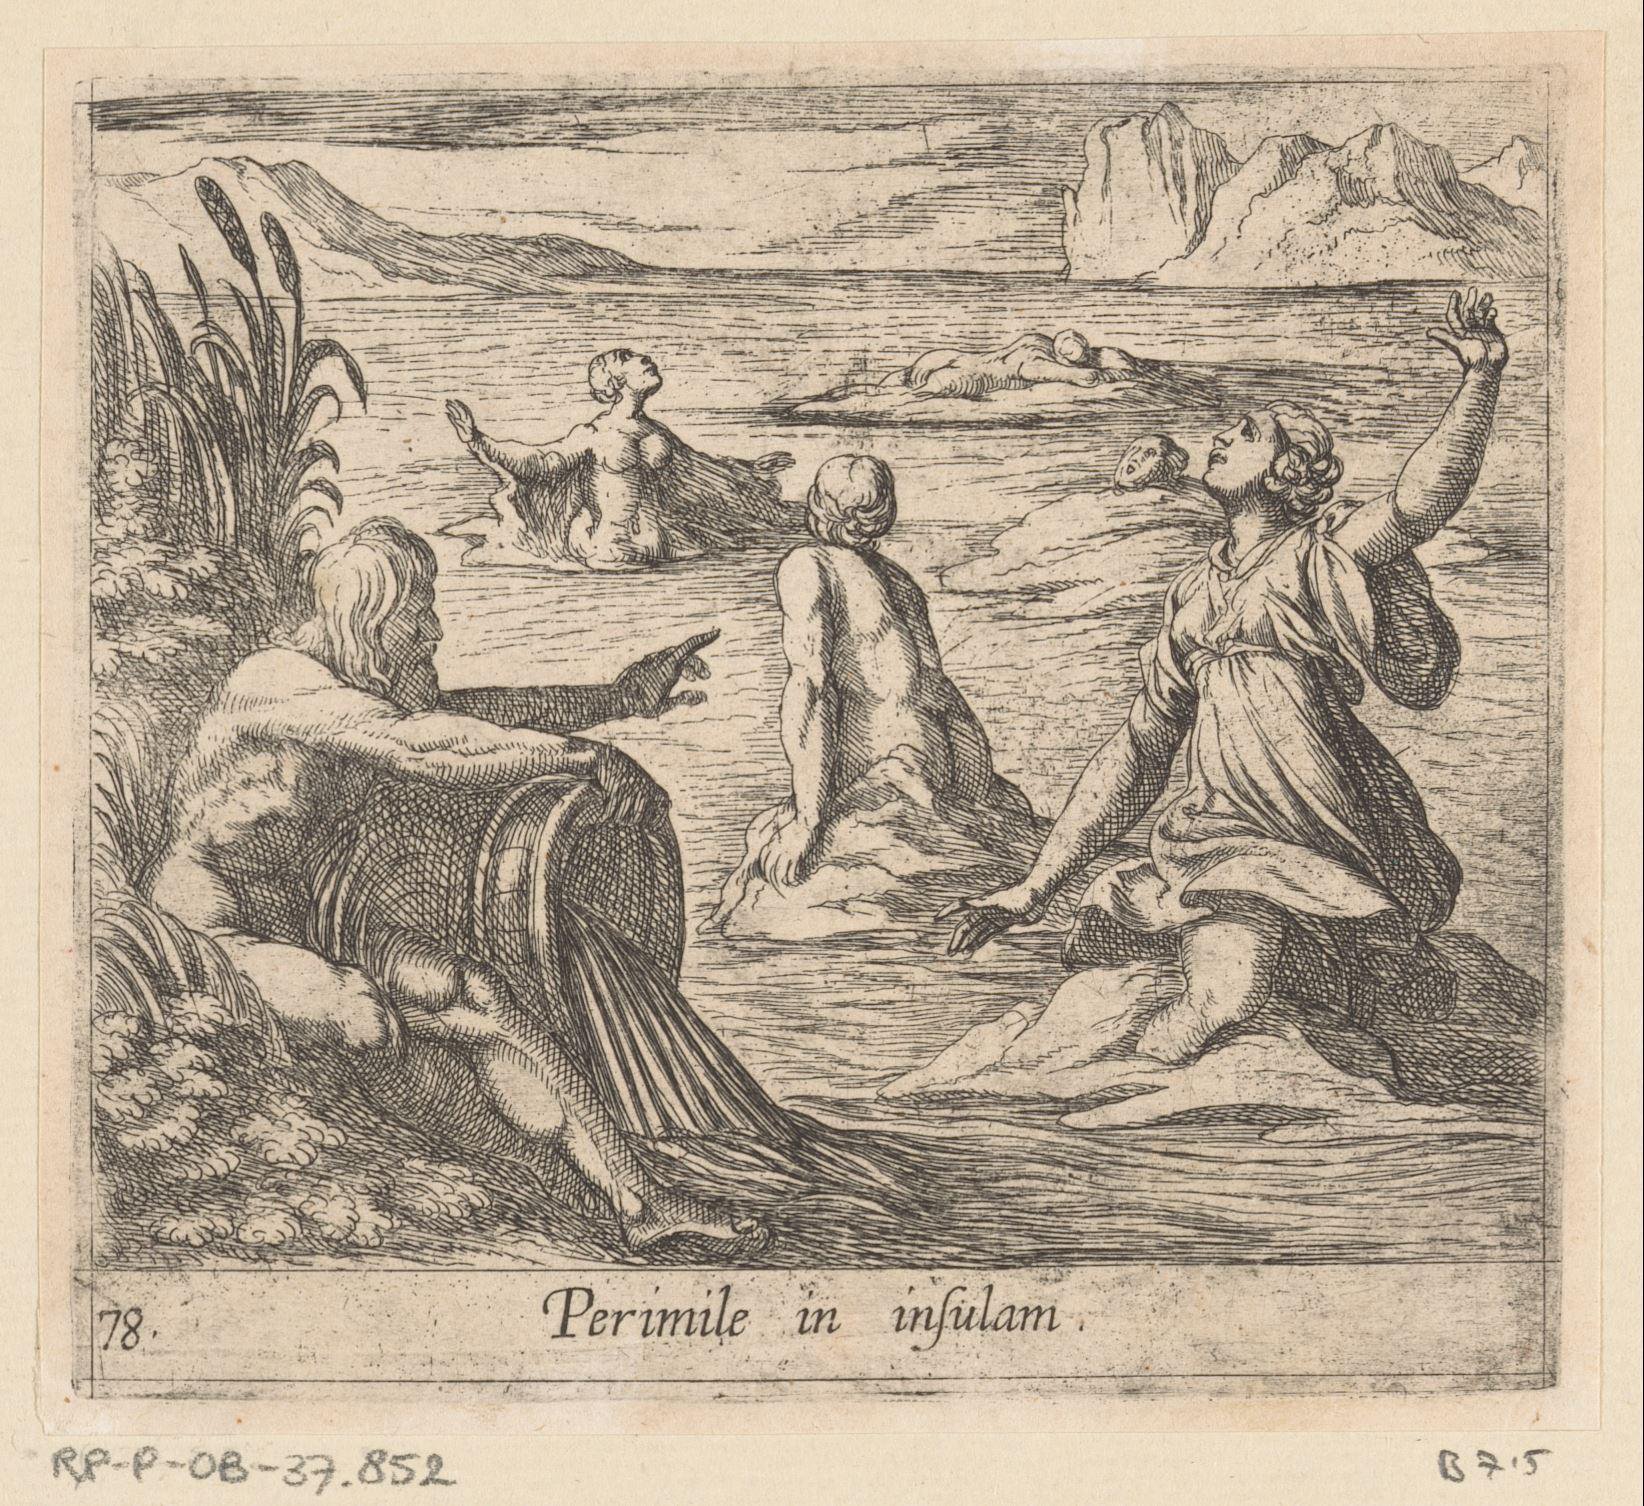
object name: print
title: Metamorphoseon sive transformationum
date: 1606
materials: paper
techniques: etching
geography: antwerp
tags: perimele changed into an island: perimele, when thrown into the sea by her father hippodamas, is changed into an island by neptune, at achelous' request (ovid, metamorphoses viii 609)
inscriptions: collector's mark: Lugt 240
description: Perimele wordt in zee gegooid door haar vader Hippodamas en veranderd in een eiland door Neptunus. Op de voorgrond links een riviergod. Titel in het Latijn in ondermarge.